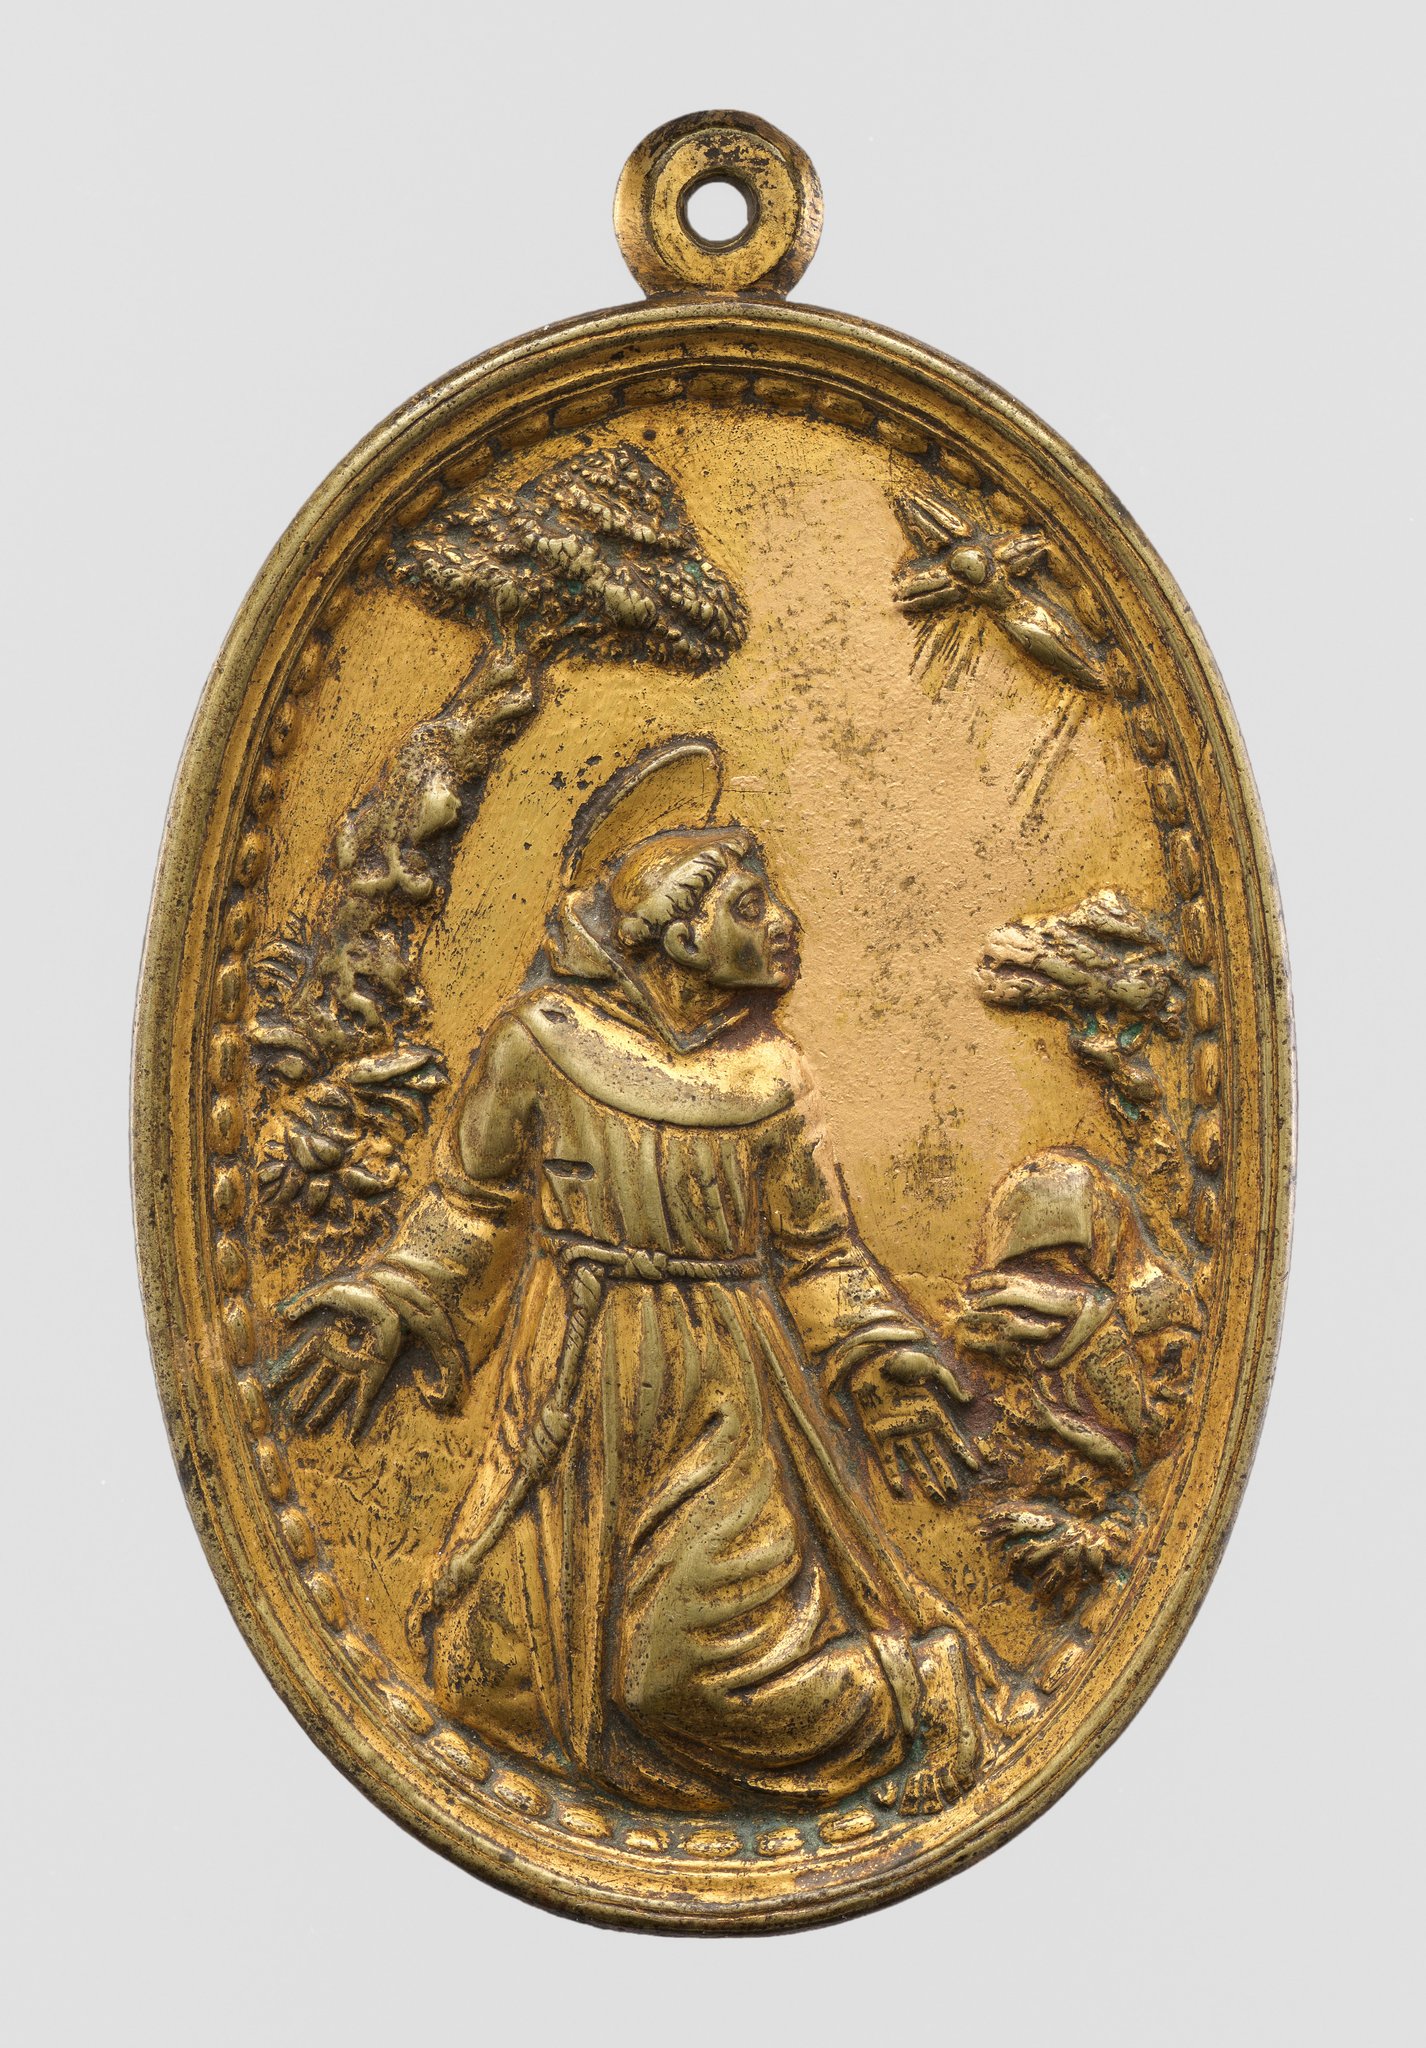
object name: plaquette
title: Saint Francis of Assisi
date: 1601-1700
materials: gilt bronze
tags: saint francis